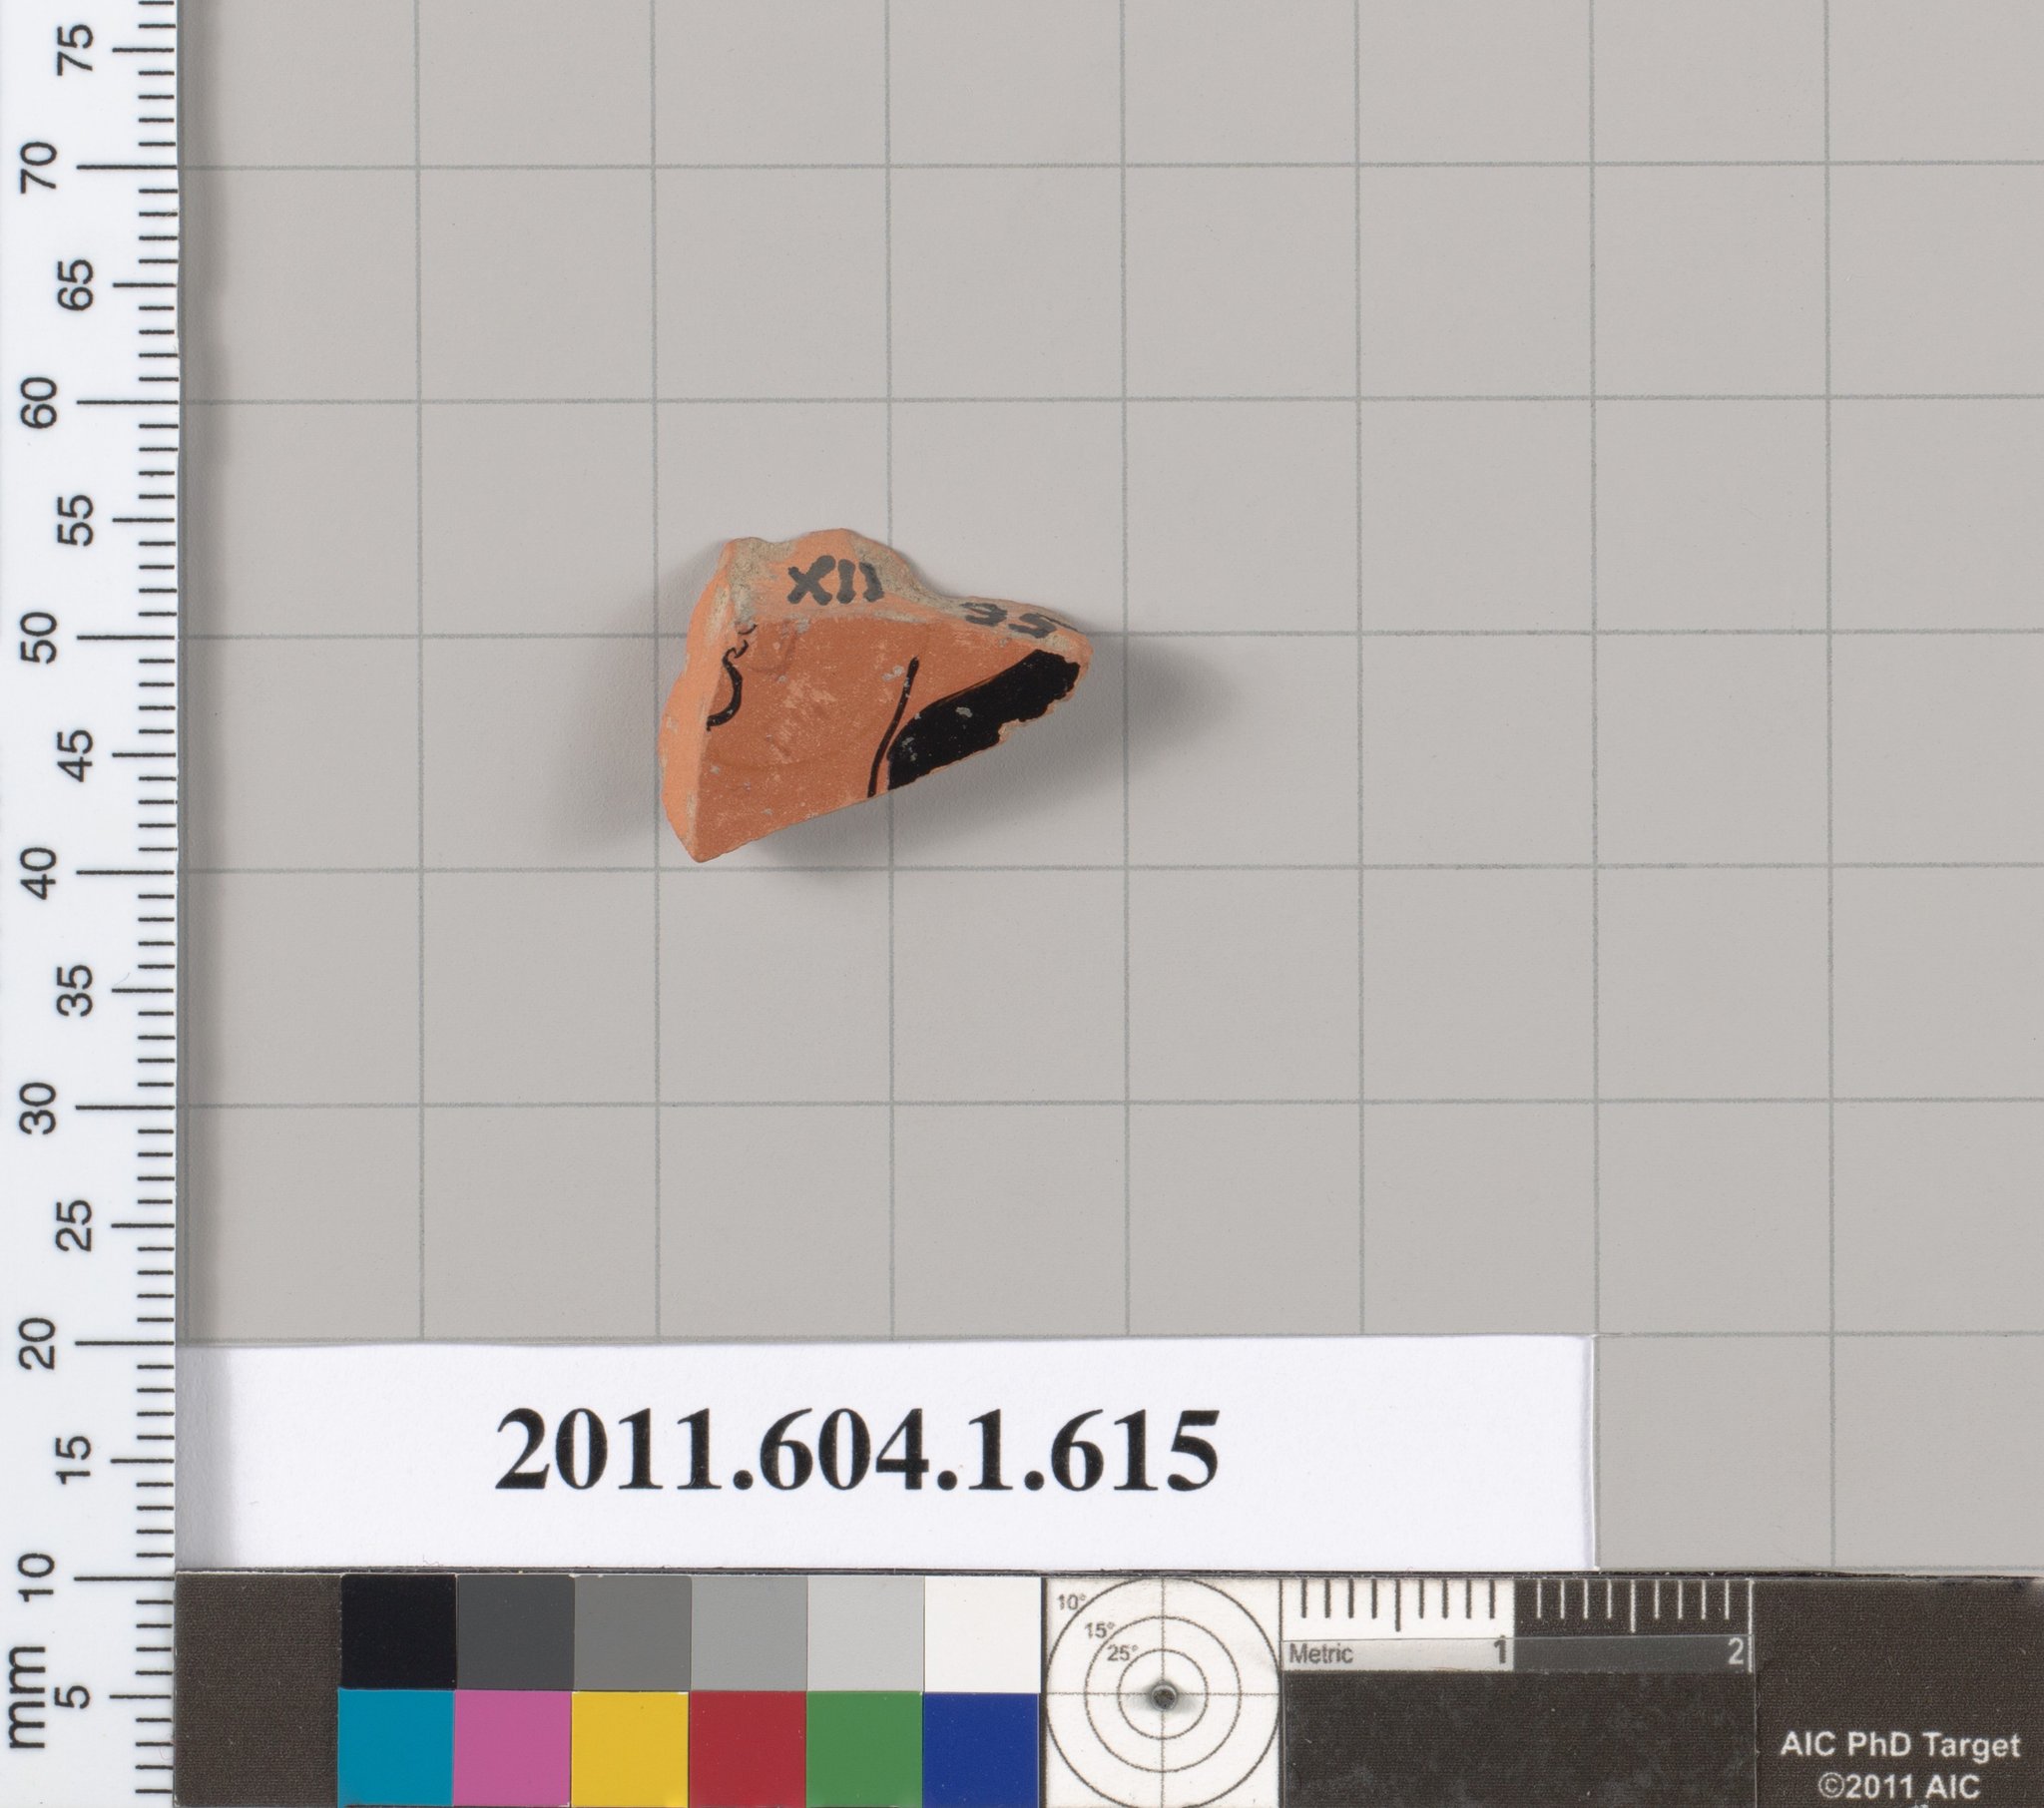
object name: kylix fragment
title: Terracotta fragment of a kylix (drinking cup)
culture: greek, attic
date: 475-451 BCE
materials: terracotta